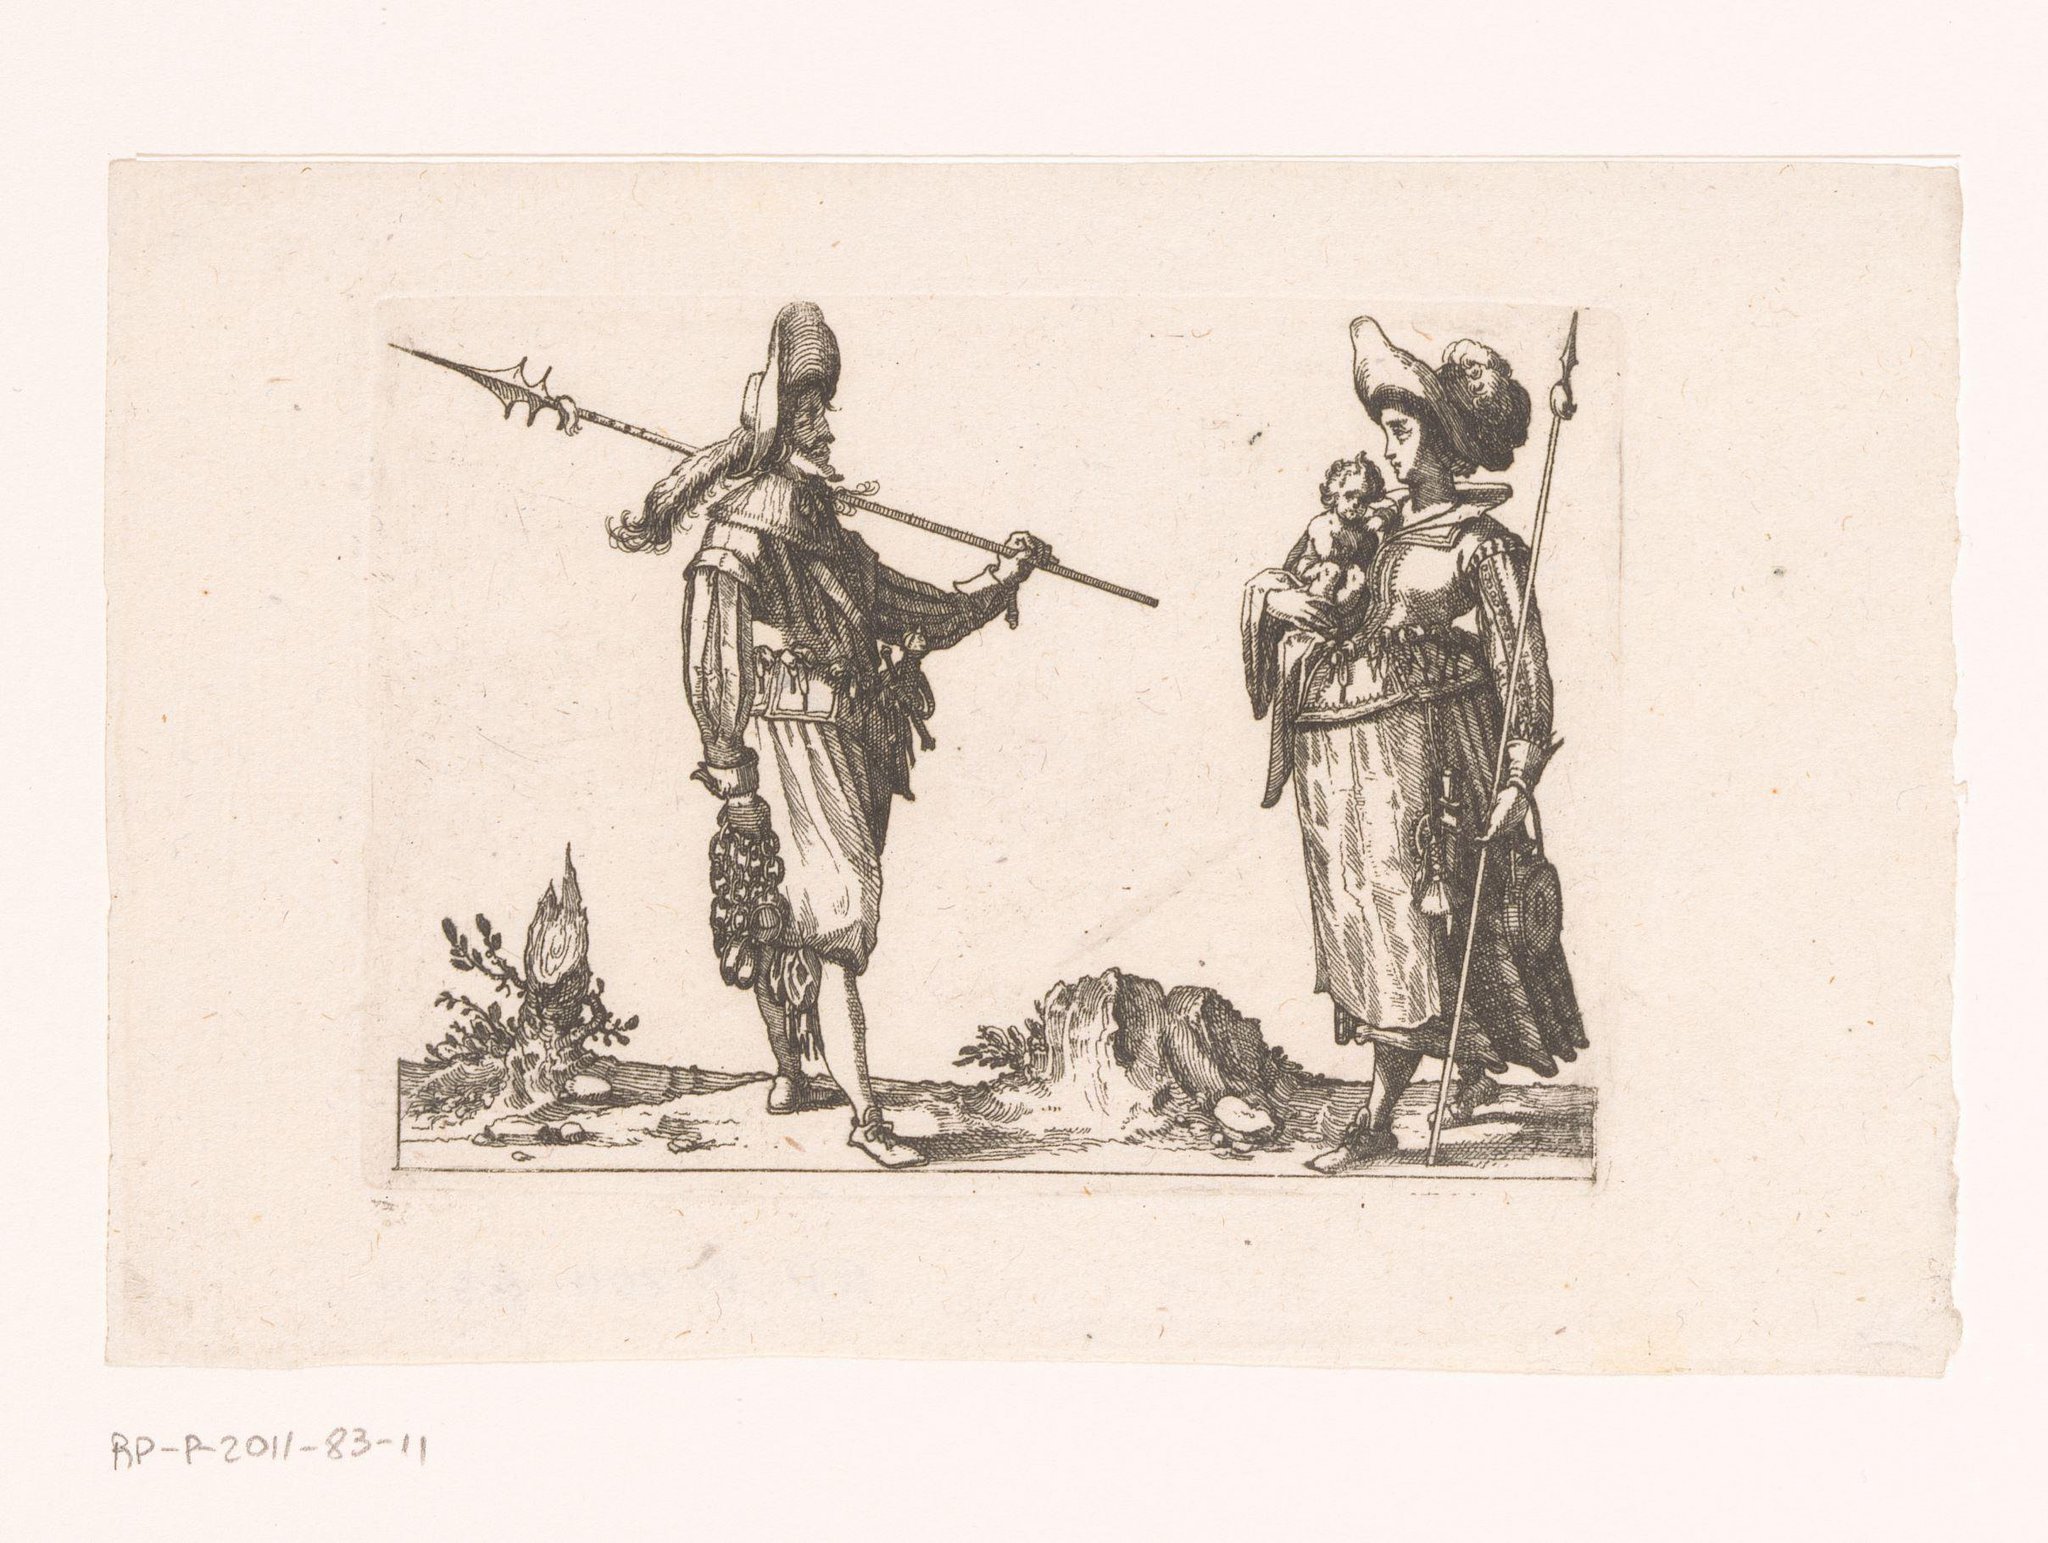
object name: print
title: Soldaten en edelmannen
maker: rudolph meyer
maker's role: print maker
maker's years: 1605-1638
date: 1615-1638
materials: paper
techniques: etching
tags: helved weapons, polearms (for striking, hacking, thrusting): pike, family life, the soldier; the soldier's life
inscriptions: collector's mark: Lugt 2233, collector's mark: Lugt 2228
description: Onderdeel van een serie van zestien voorstellingen van soldaten (Soldatenbüchli).